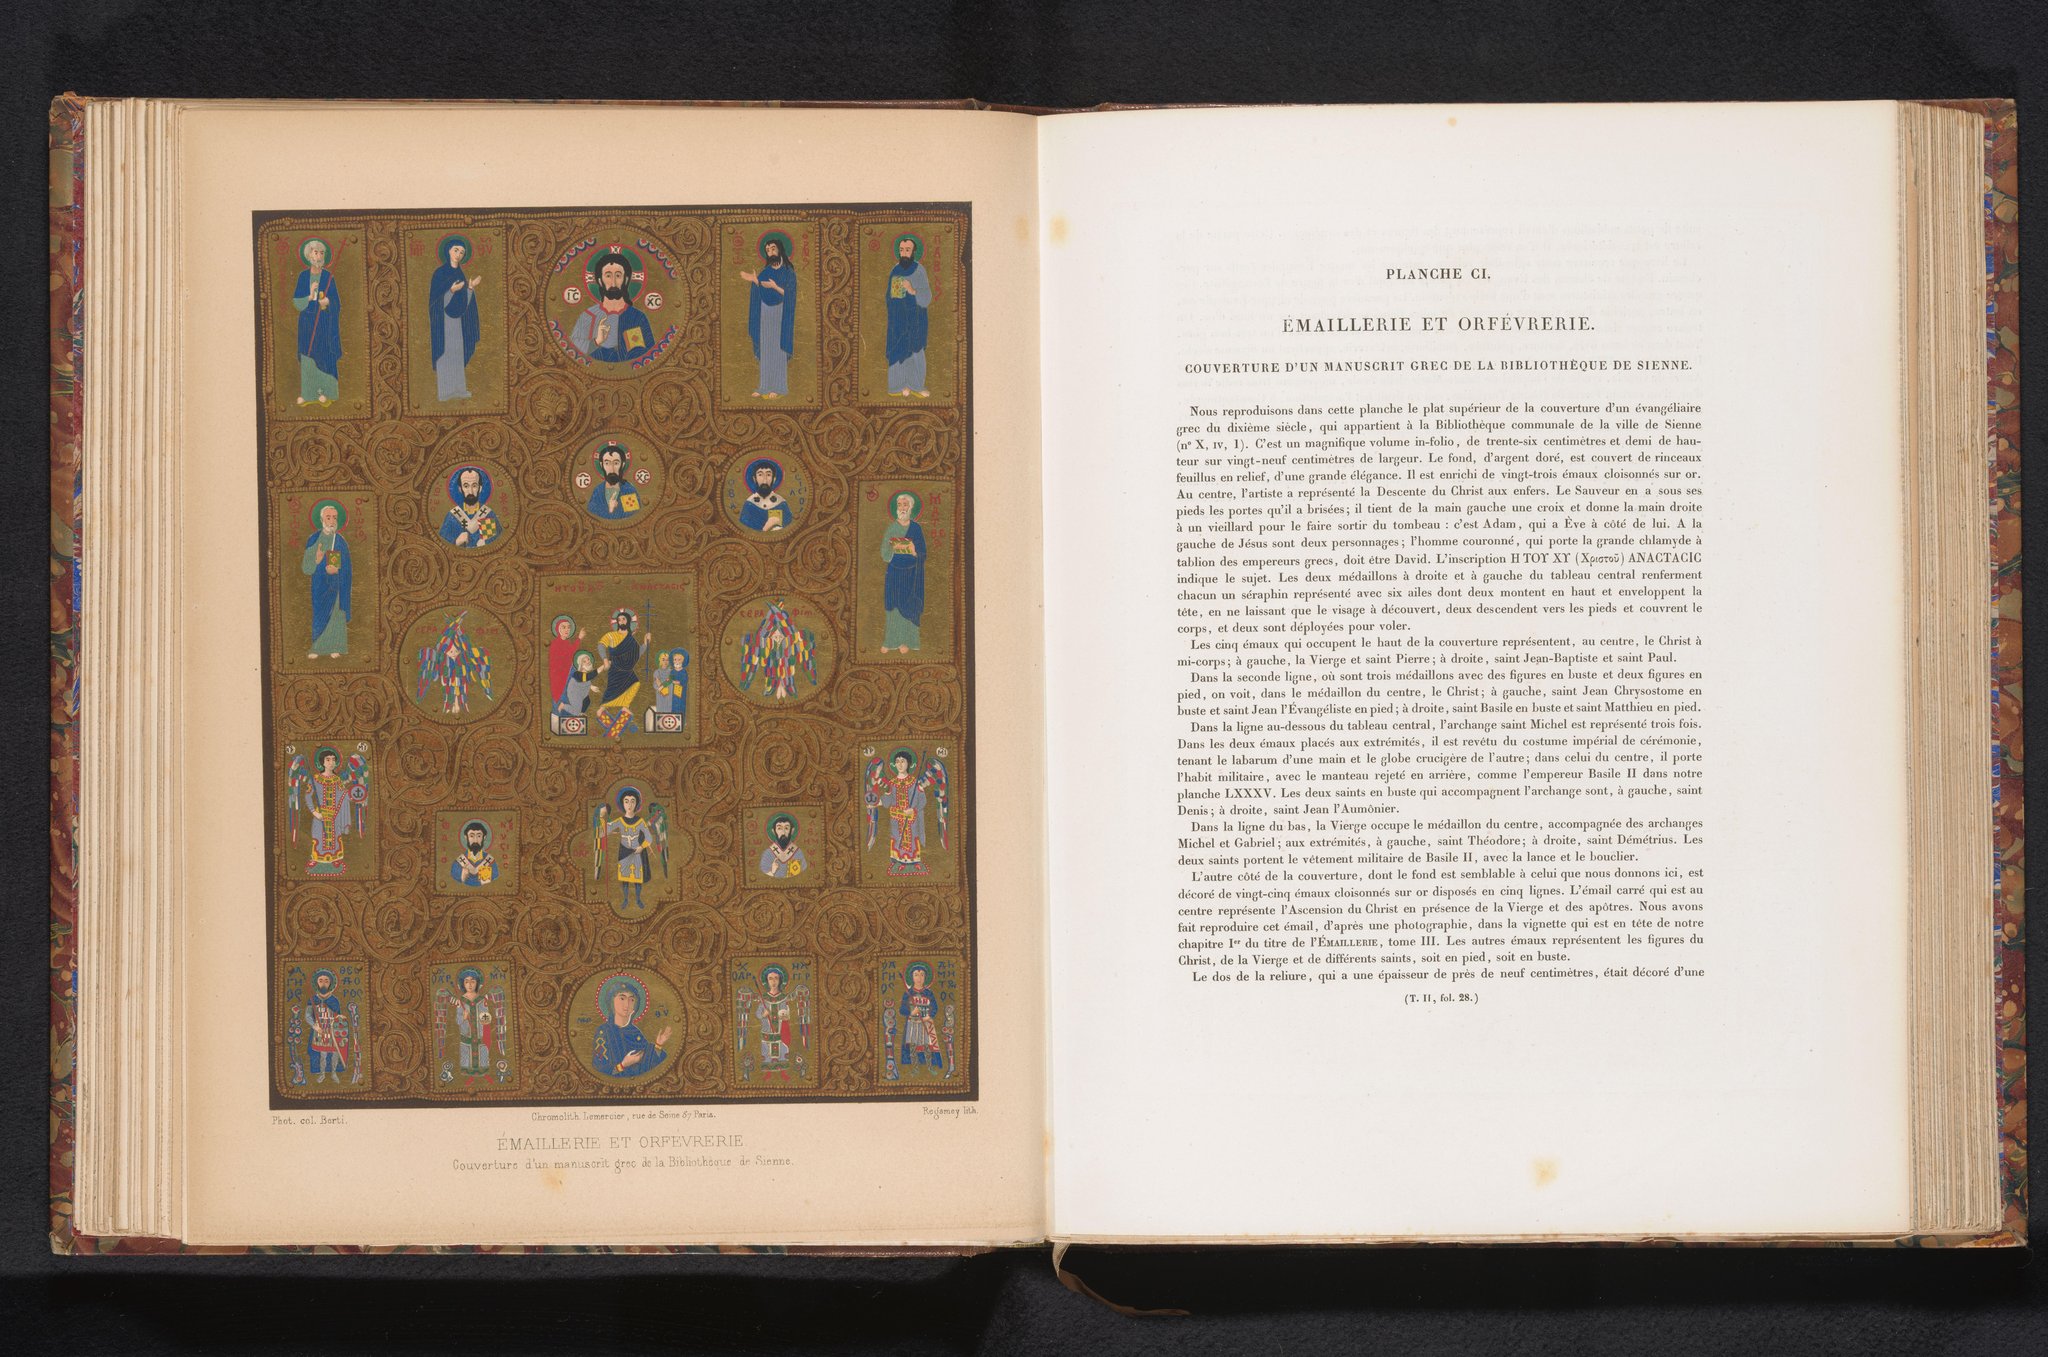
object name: page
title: Couverture d'un manuscrit grec de la Bibliothèque de Nienne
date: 1859-1864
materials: paper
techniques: photolithography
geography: paris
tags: saints, christ, book-cover, binding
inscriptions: name: ‘Phot. col. Berti./ Moulin lith.’